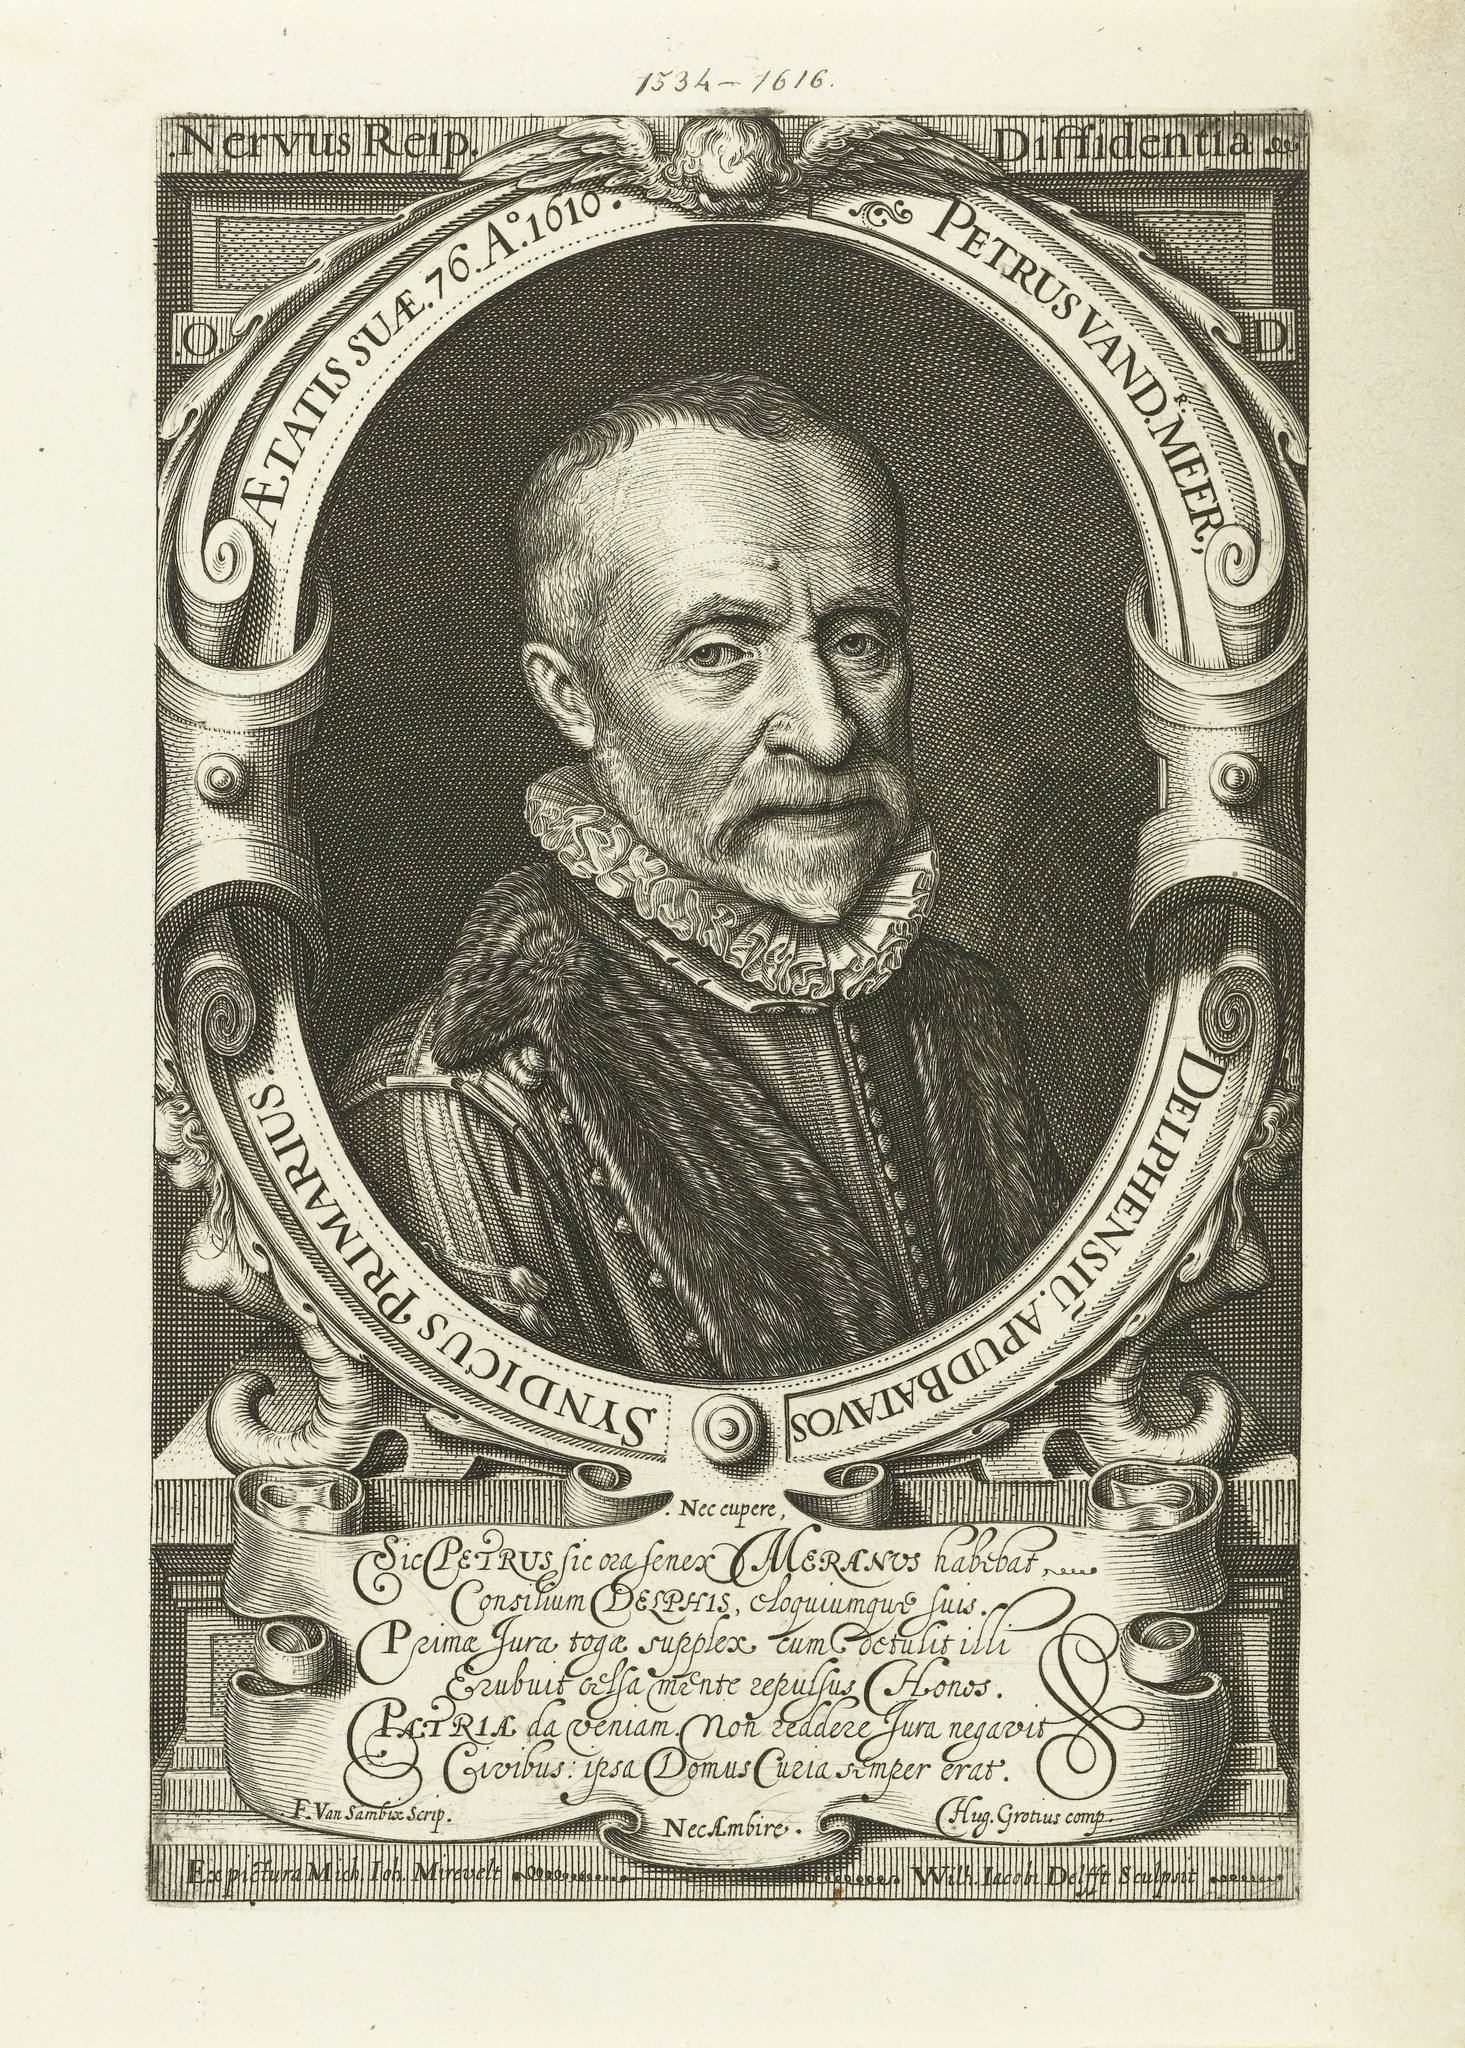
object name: print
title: Portret van Petrus van der Meer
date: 1610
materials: paper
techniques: engraving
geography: delft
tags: pensionaris, petrus van der meer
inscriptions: date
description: Portret van Petrus van der Meer, borststuk in toga in ovale omlijsting. Onder het portret een cartouche met vers van Hugo de Groot.